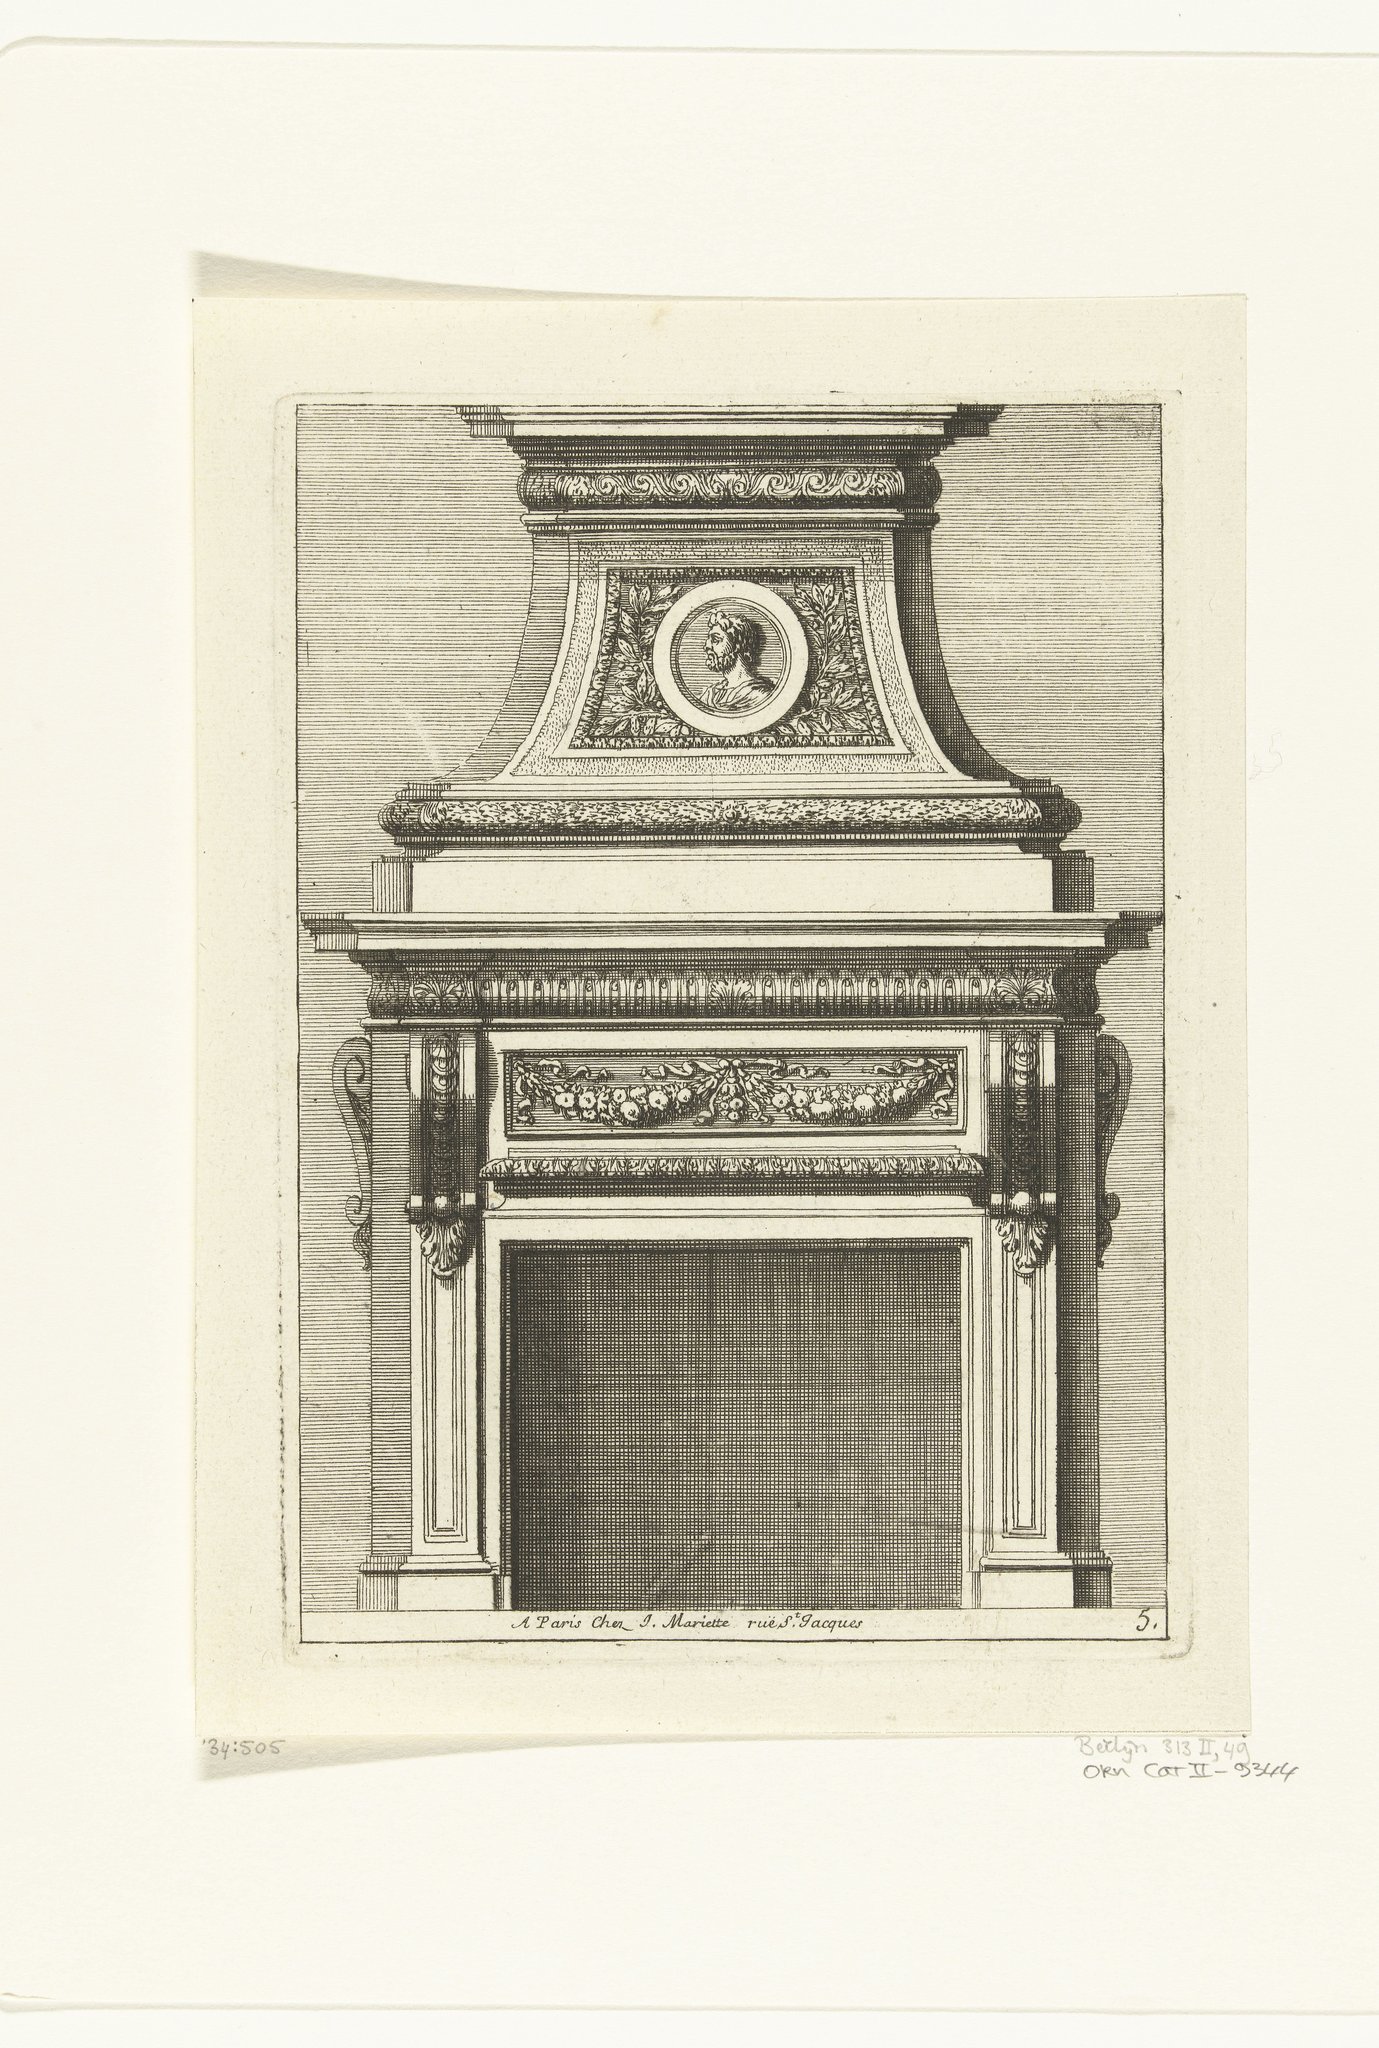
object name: ornament print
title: Onderboezem met portretmedaillon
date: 1710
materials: paper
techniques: etching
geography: paris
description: Onderboezem gedecoreerd met consoles die de architraaf ondersteunen. Uit tweede editie.